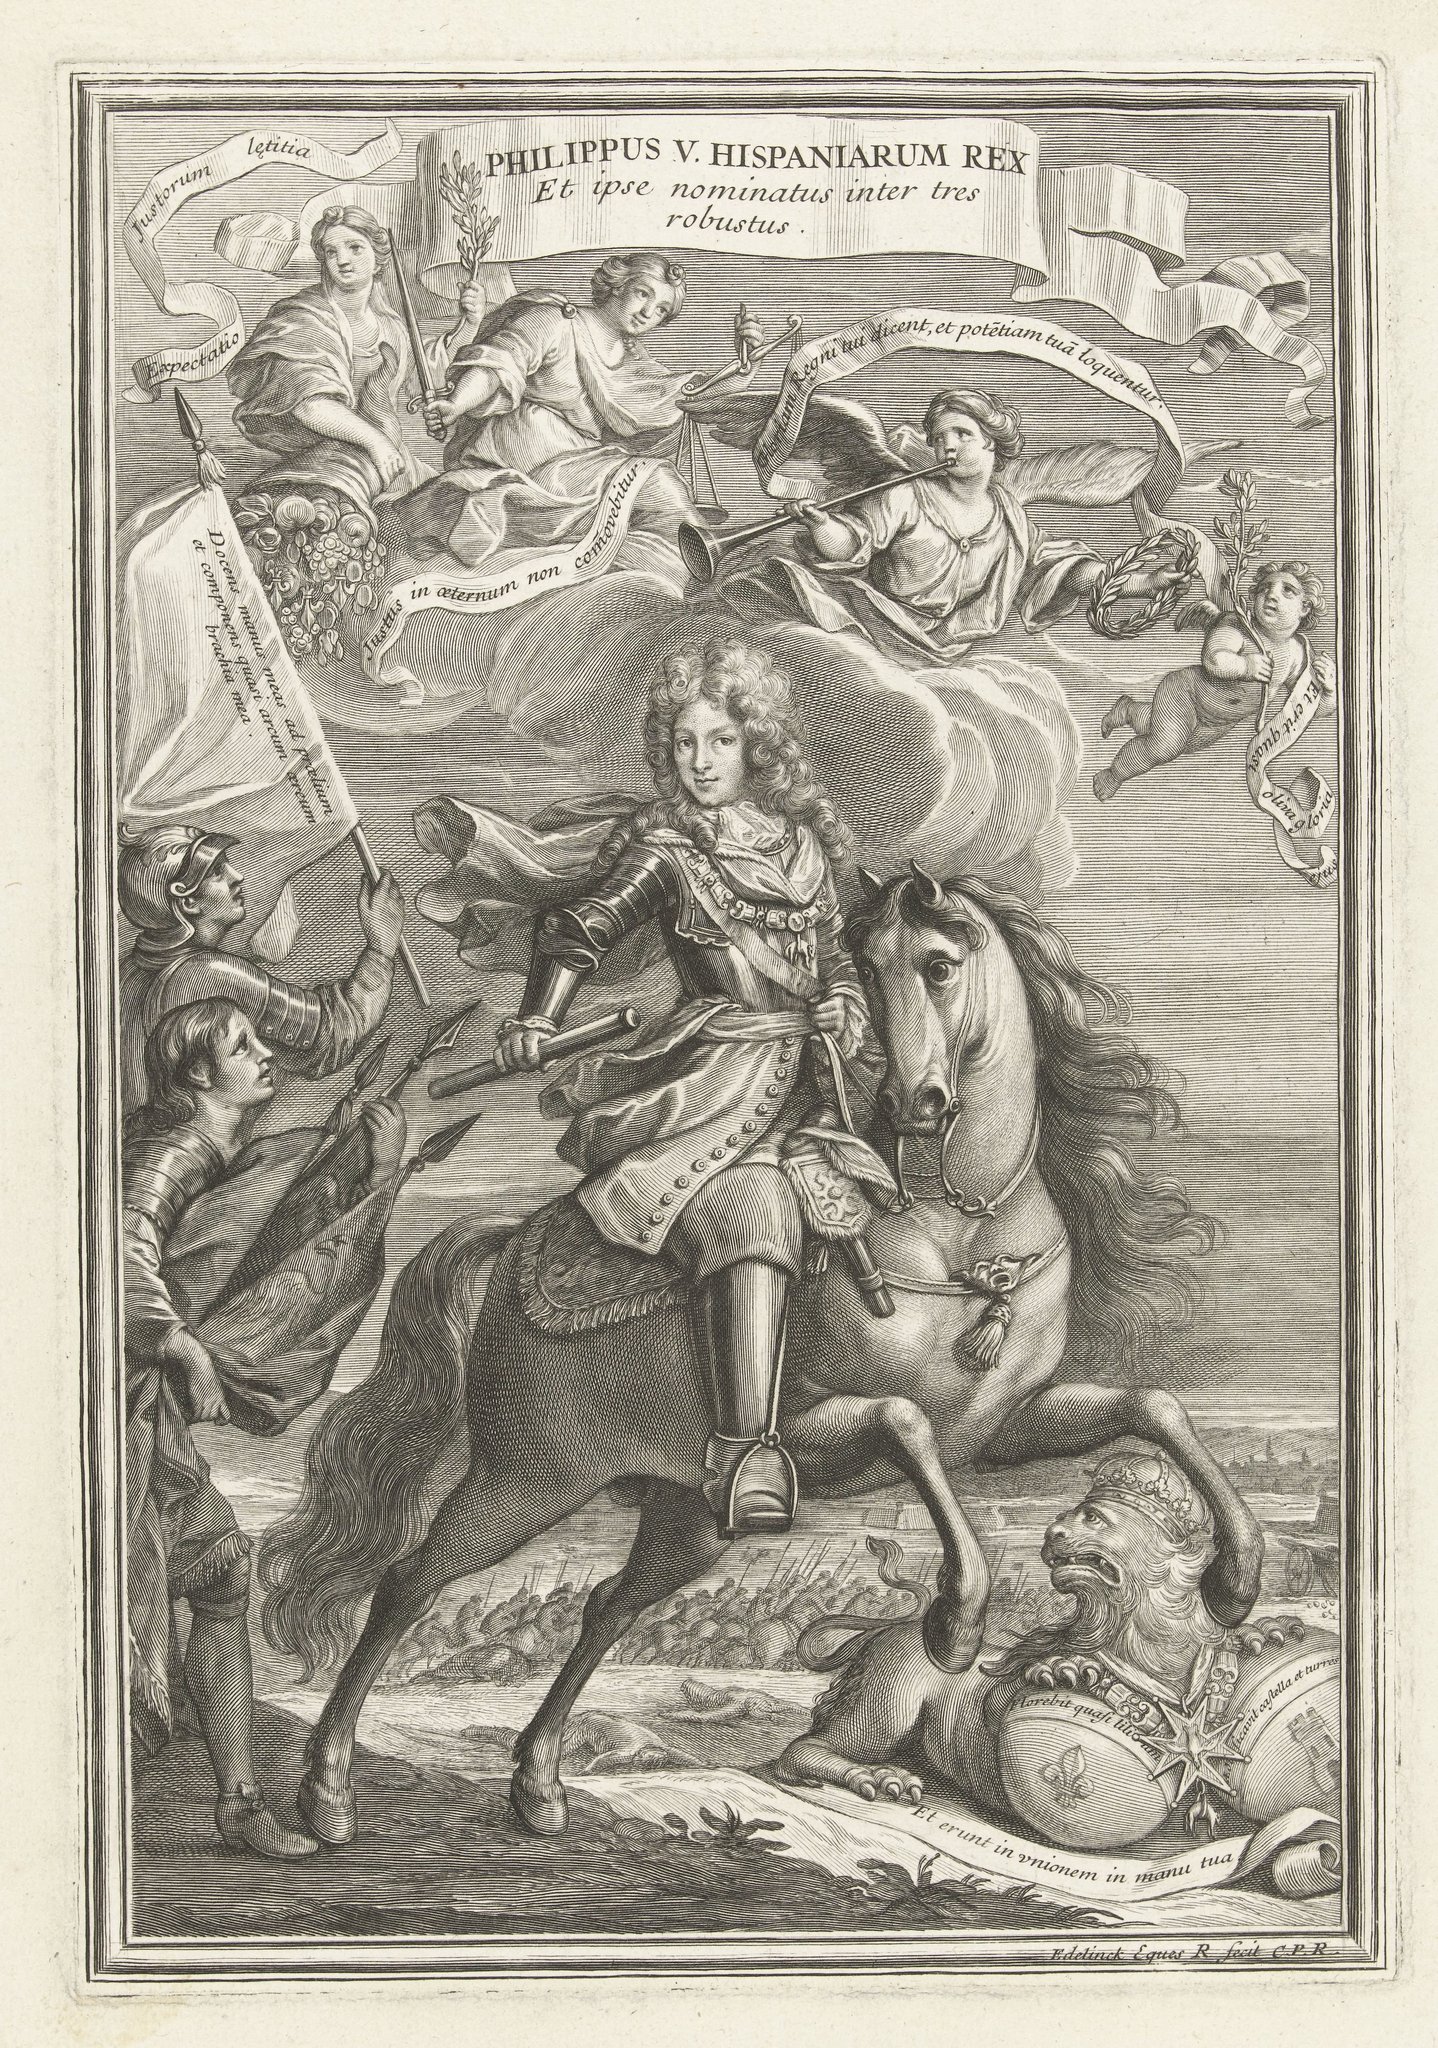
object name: print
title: Ruiterportret van Filips V van Spanje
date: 1700-1707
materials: paper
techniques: engraving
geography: france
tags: filips v (koning van spanje)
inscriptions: collector's mark: Lugt 240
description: Koning Filips V van Spanje te paard. Naast hem staan twee personen die vaandels en speren dragen, boven hem musicerende engelen en vrouwen met symbolische attributen en banderollen. Een gekroonde leeuw kijkt toe.